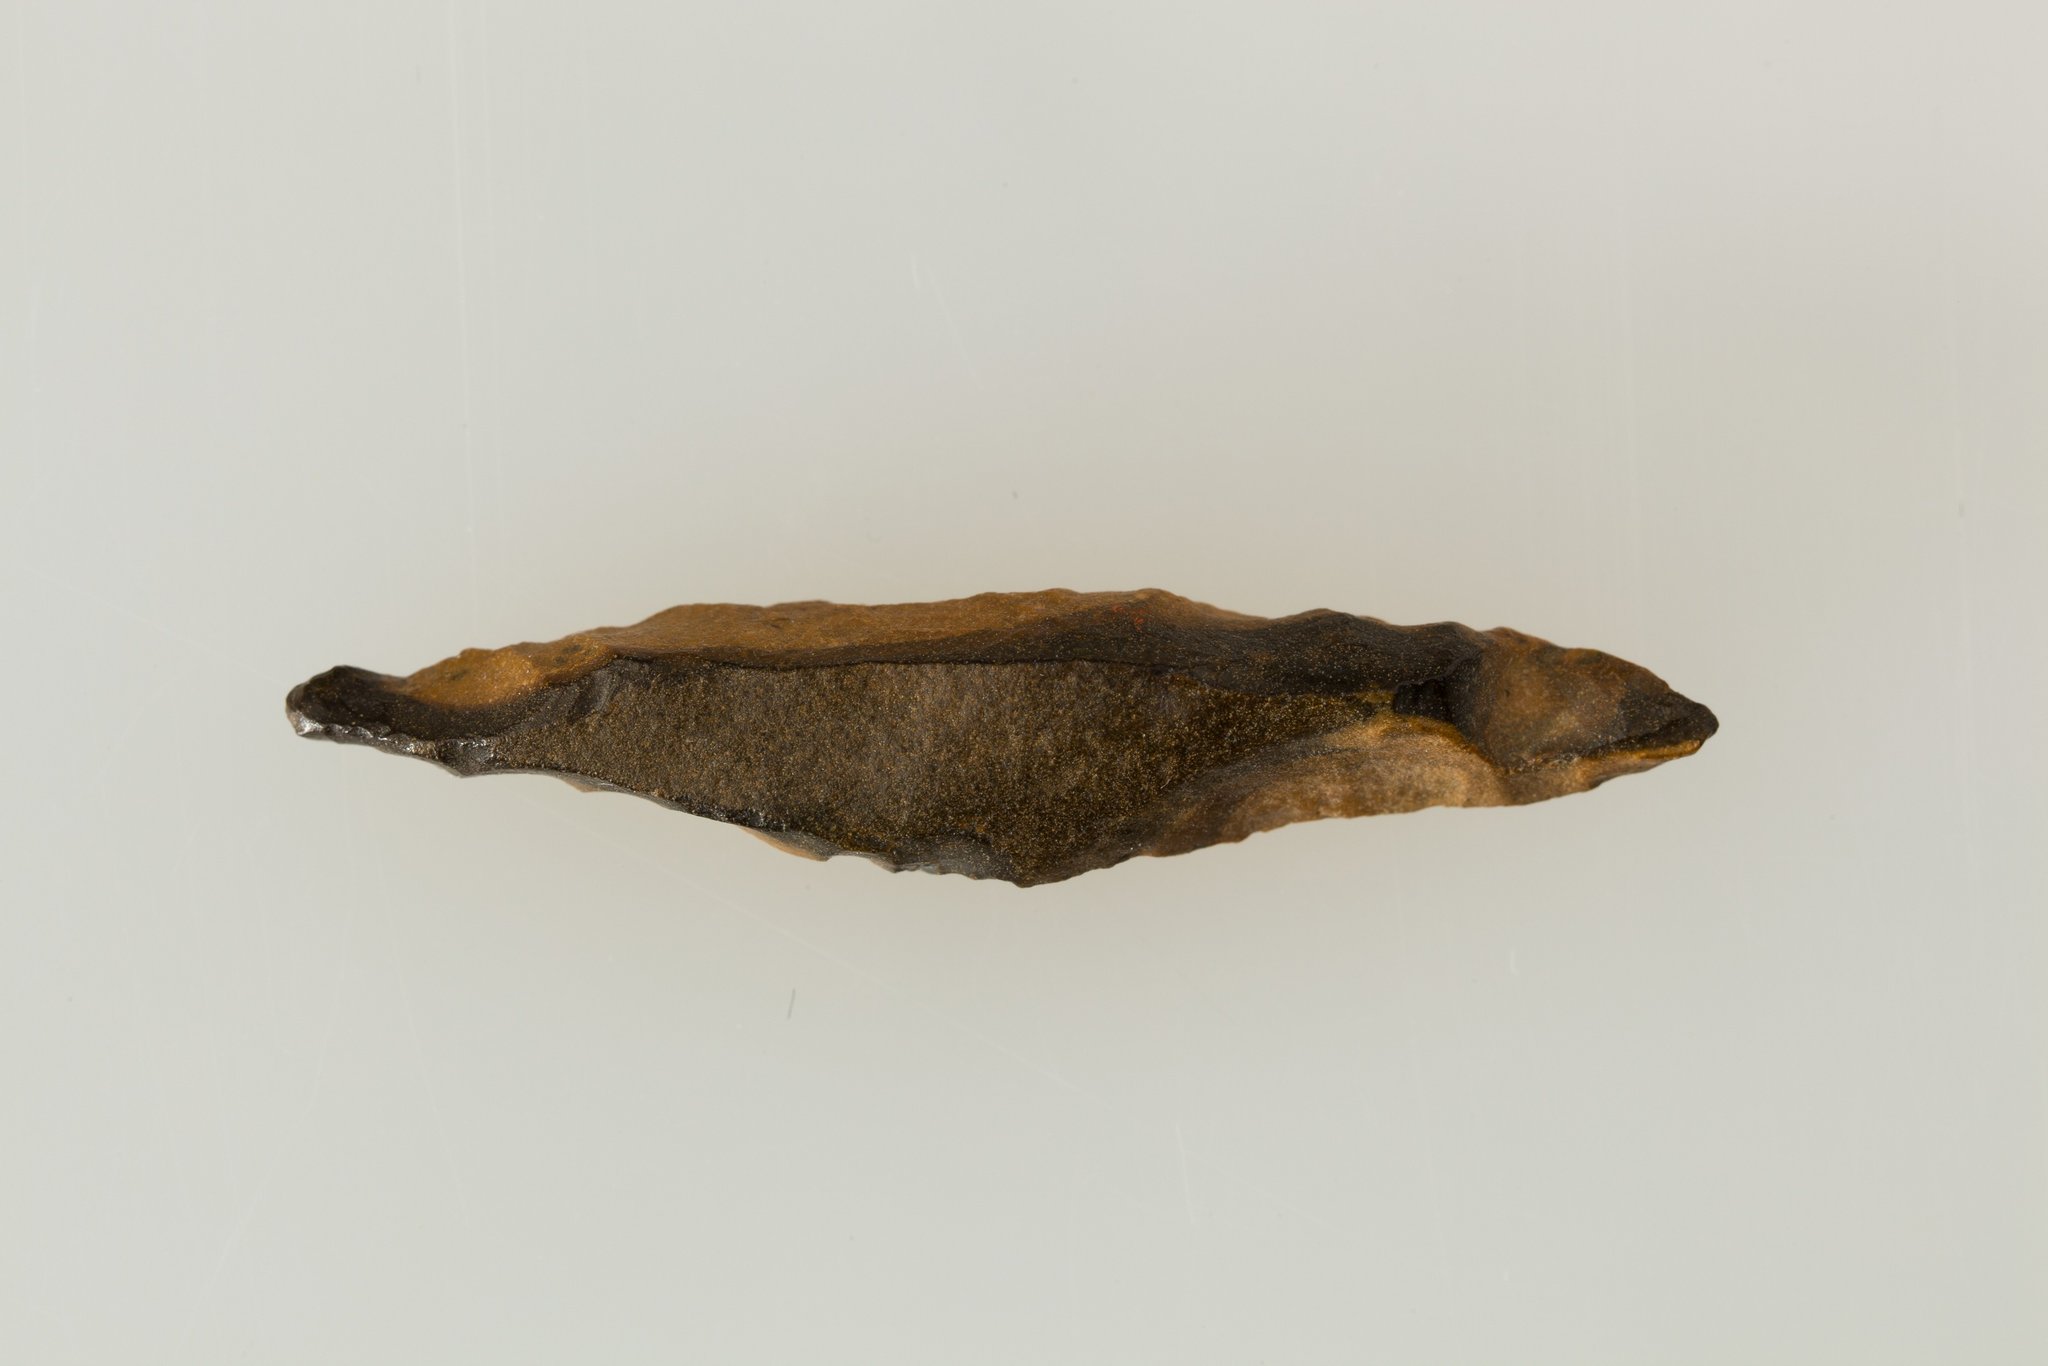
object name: tool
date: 3850-2960 BCE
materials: stone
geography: egypt